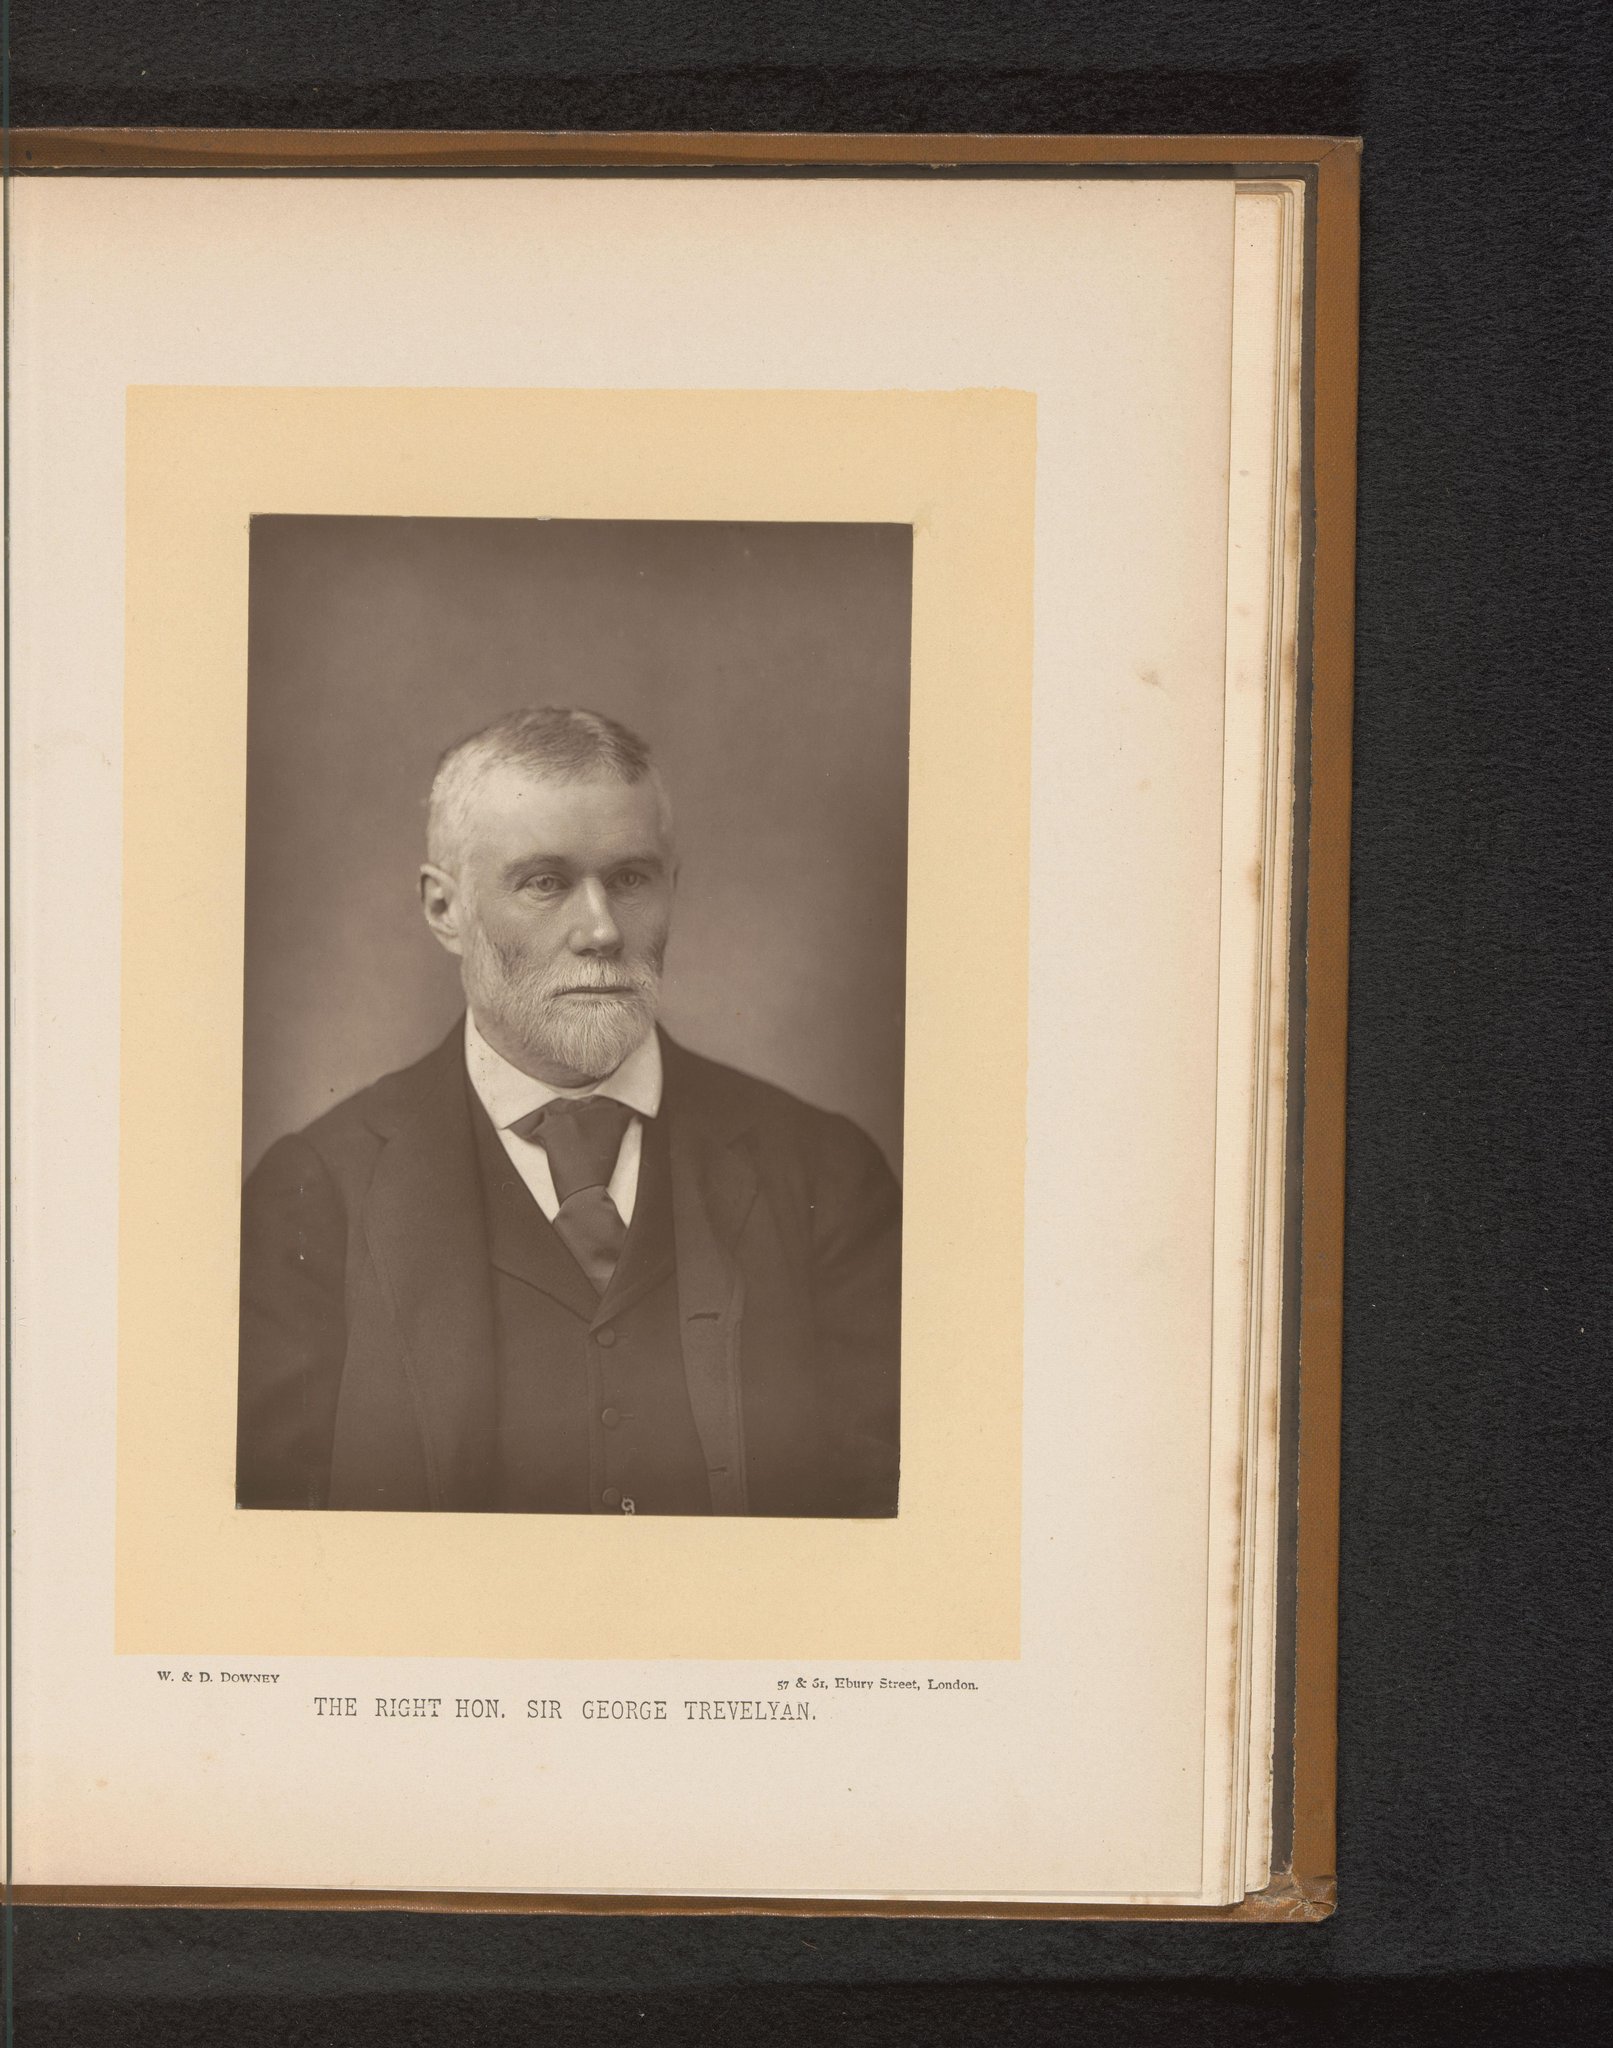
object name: photomechanical print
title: Portret van George Trevelyan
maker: Anonymous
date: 1883-1893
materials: paper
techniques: woodburytype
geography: london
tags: official; civil servant; functionary (in general), portrait of a writer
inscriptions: inscription: ‘57 & 61, Elbury Street, London.’